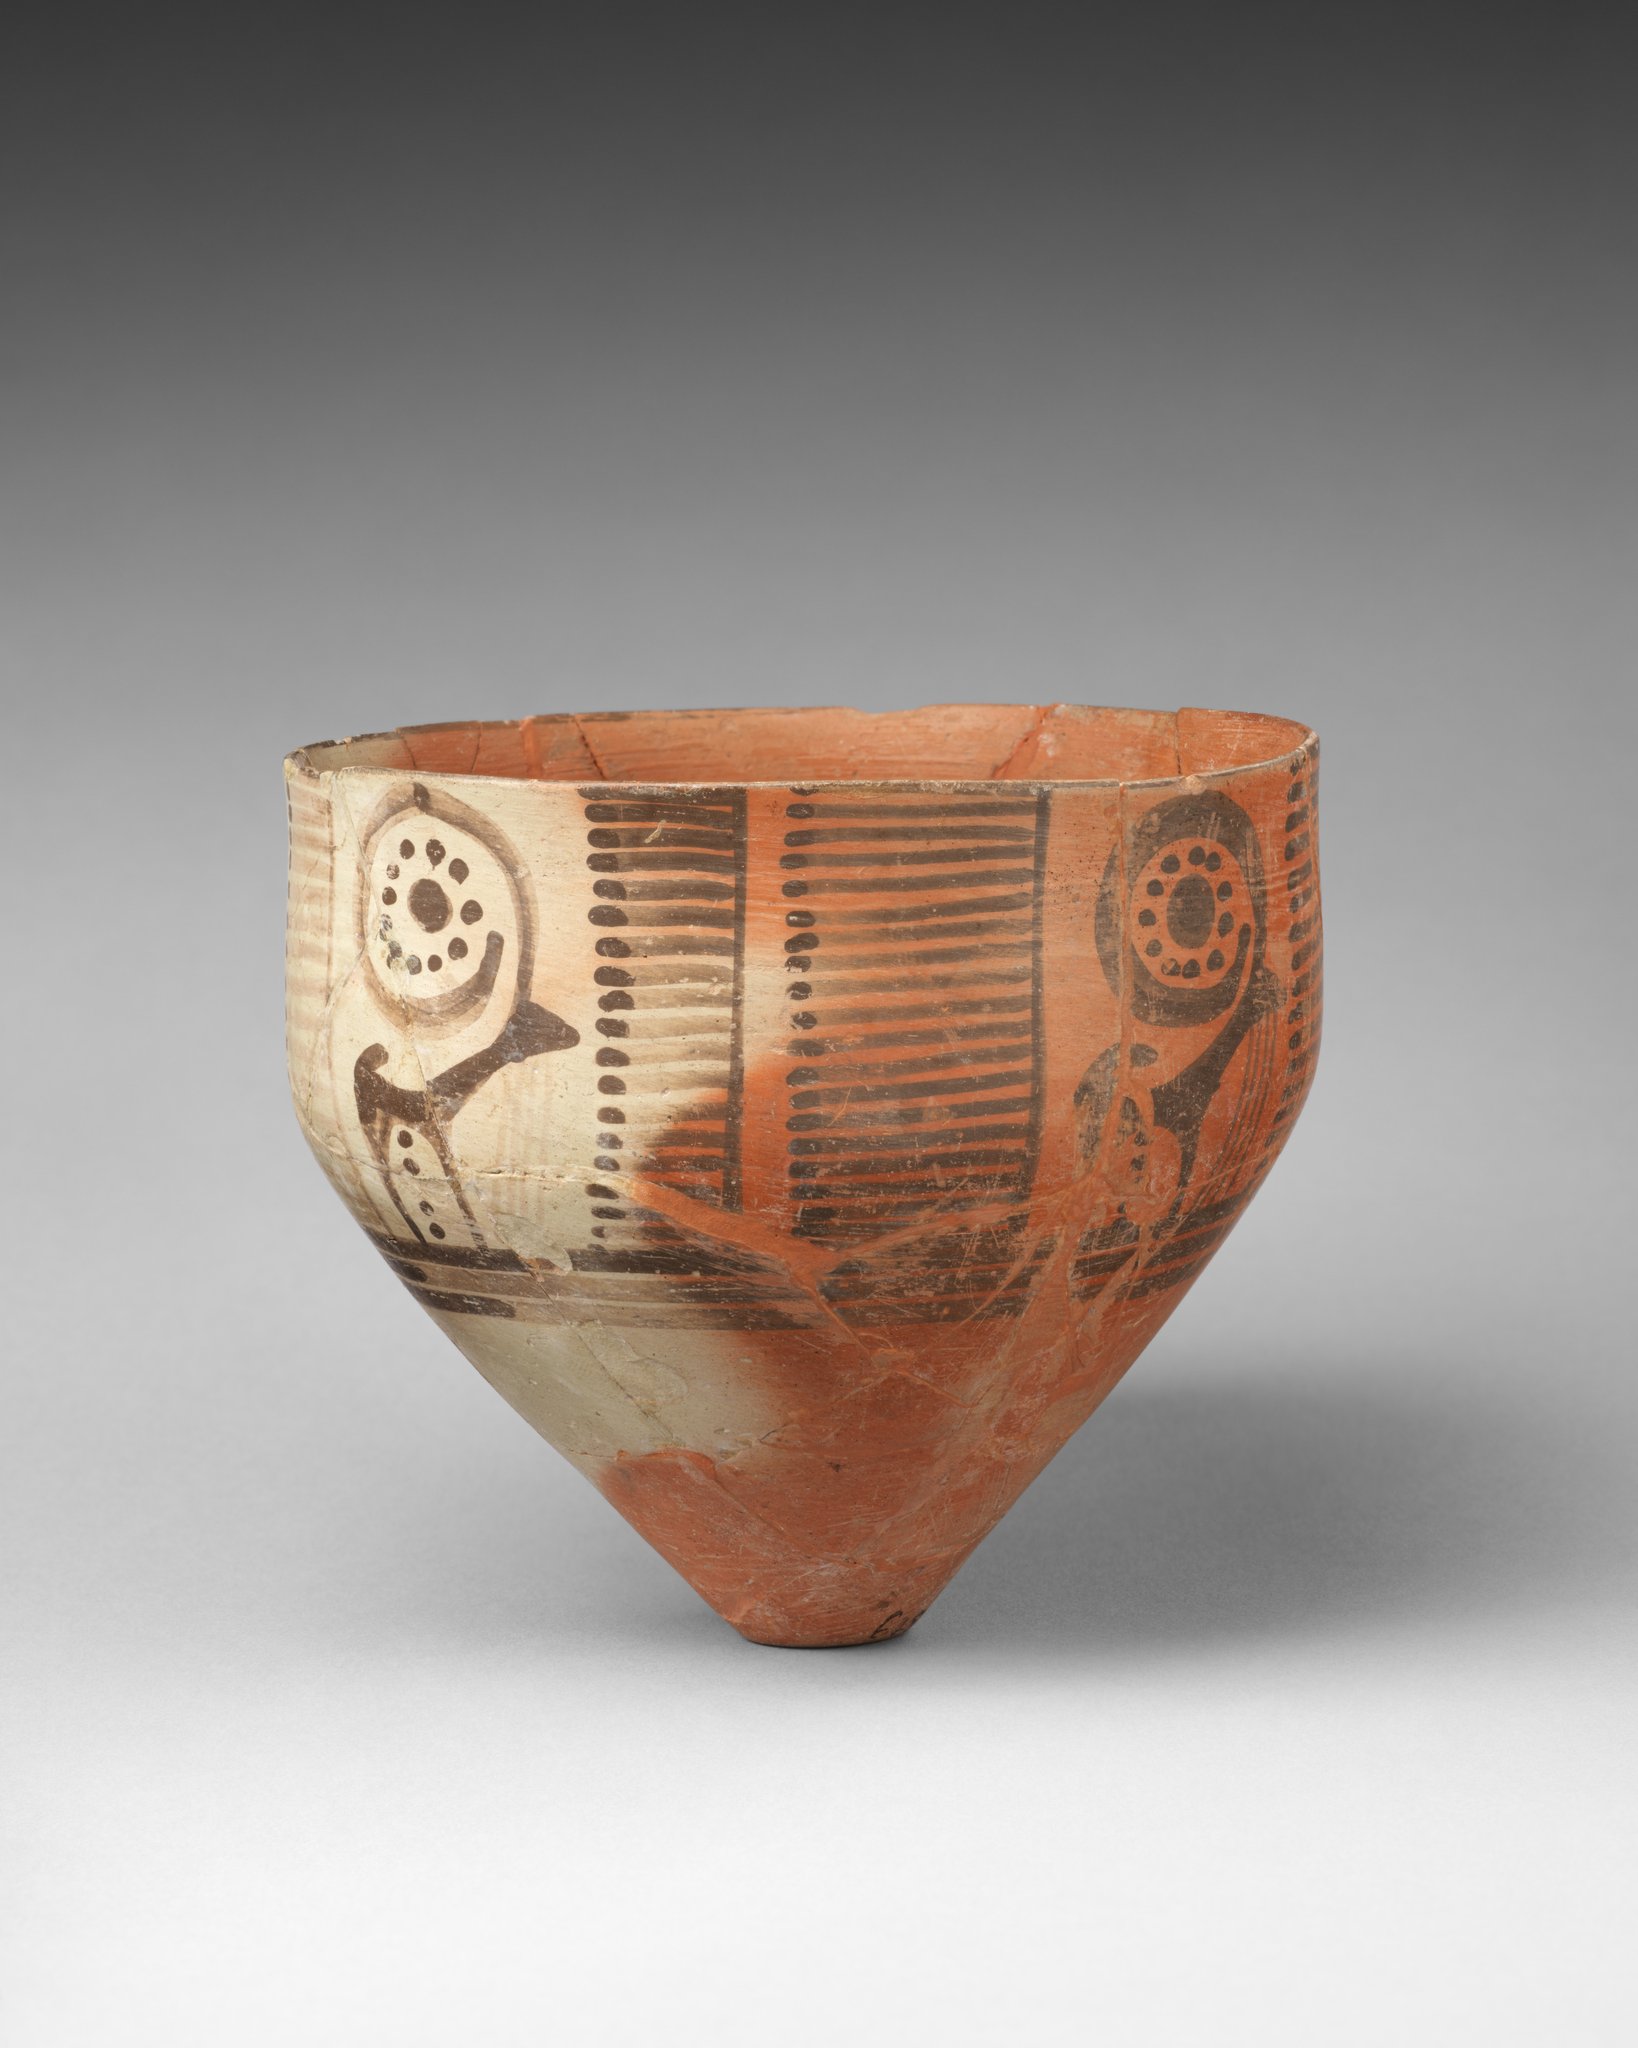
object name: cup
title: Cup decorated with ibexes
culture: iranian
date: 4000 BCE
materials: ceramic, paint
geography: iran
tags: ibex